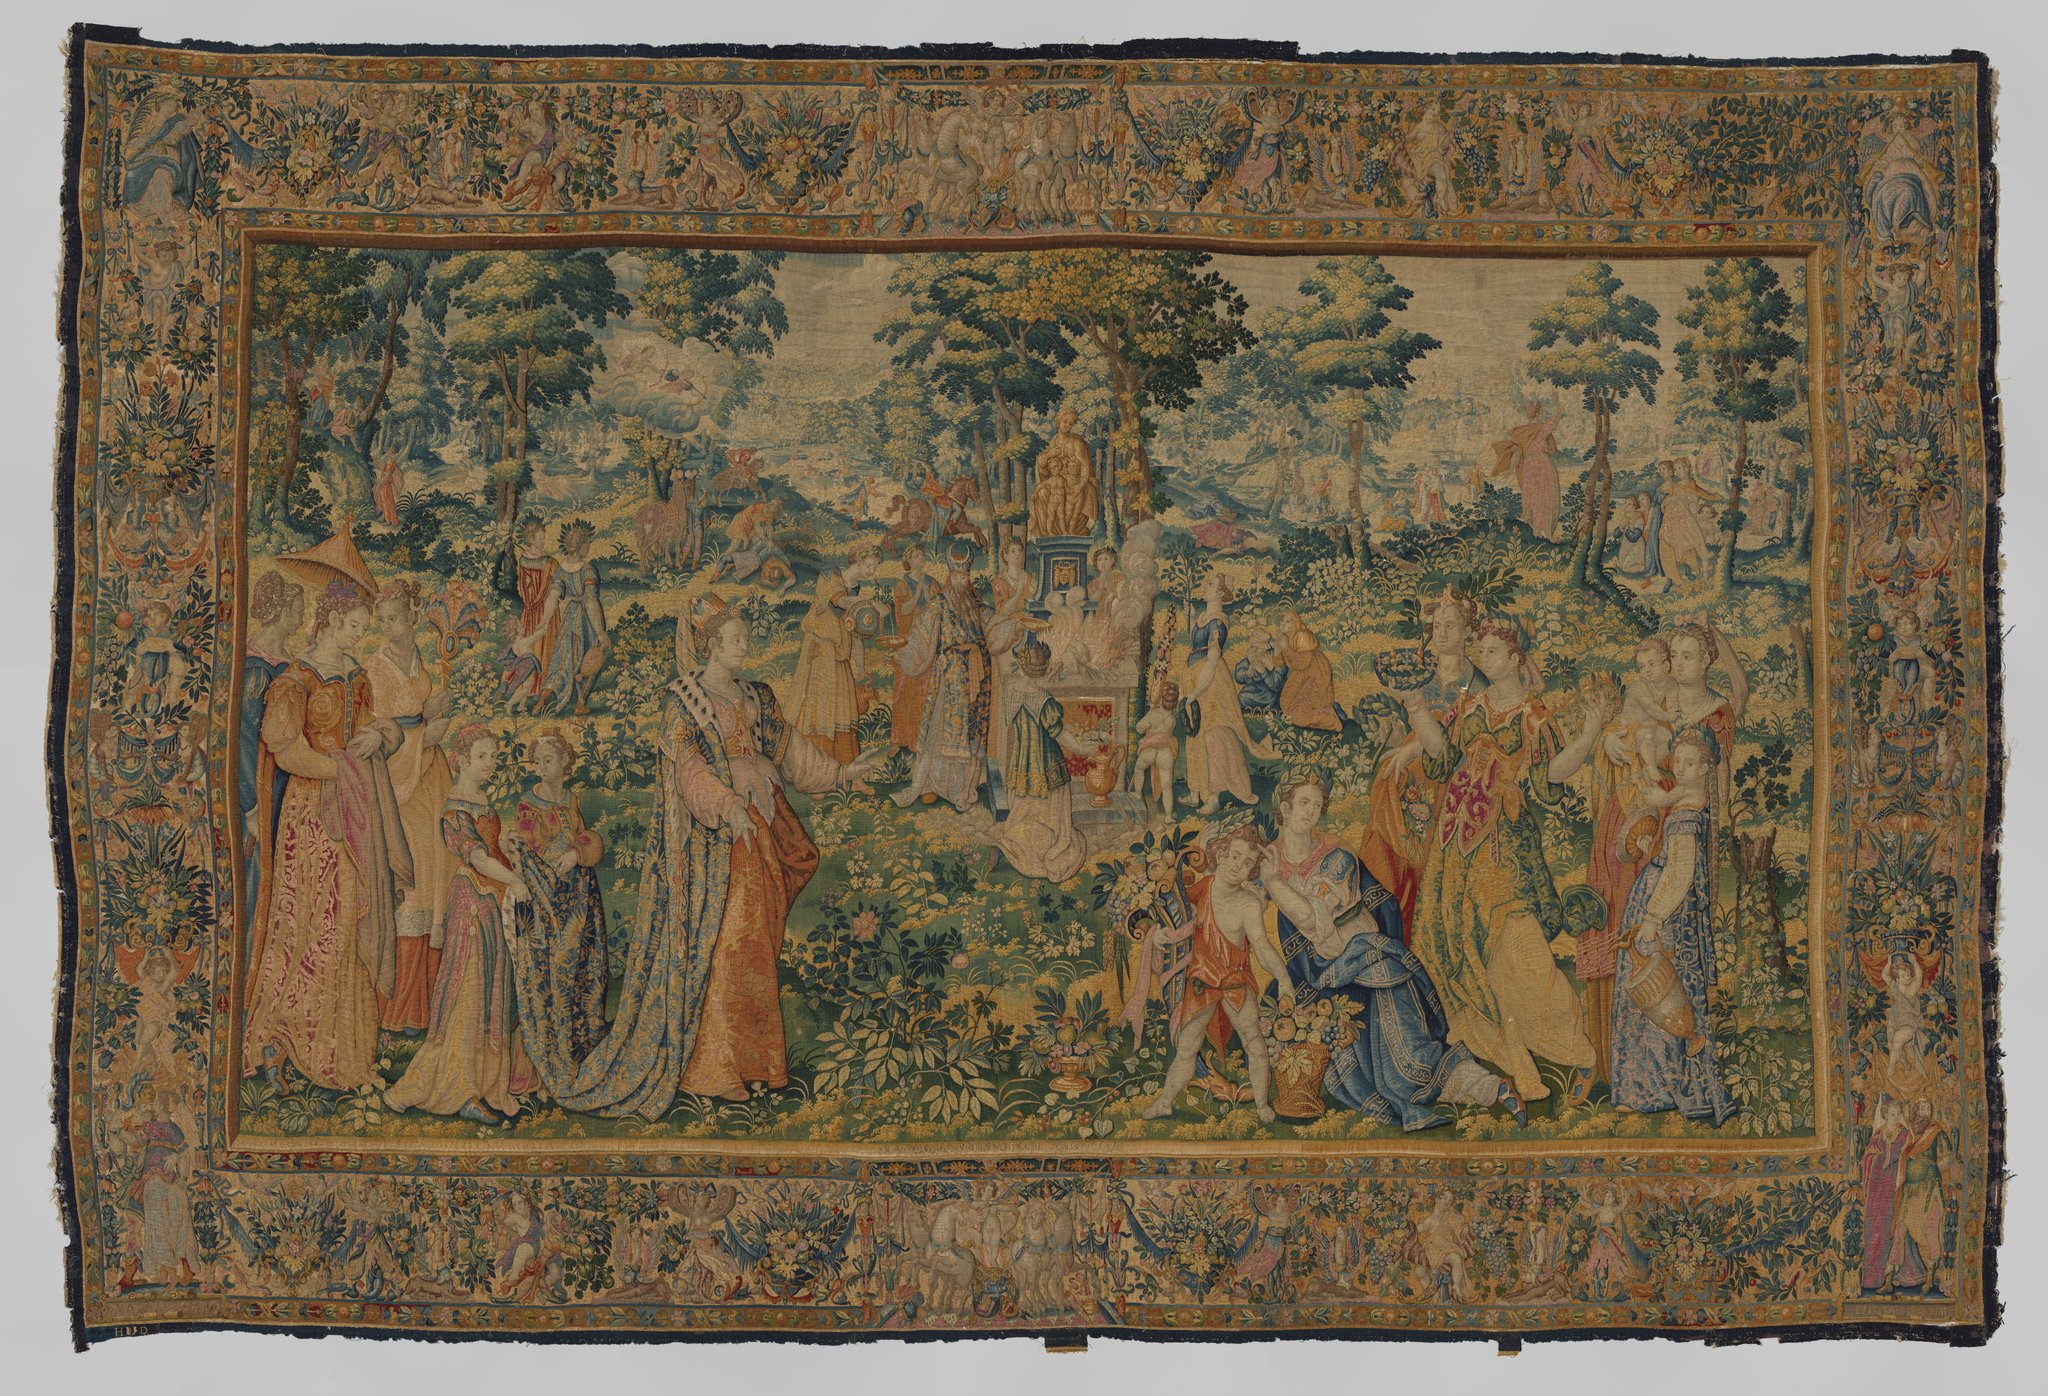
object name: tapestry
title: De geschiedenissen van Diana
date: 1610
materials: silk, wool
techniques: tapestry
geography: delft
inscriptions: inscription: ‘IVPITER ET CALLISTO’, mark, mark, signature and date: ‘FRANCISCVS.SPIRINVS.FECIT.ANNO 1610’, inscription: ‘MARS ET VENUS’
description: Niobe gekleed in een blauwe mantel van 14de eeuws Lucca brocaat, afgezet met hermelijn, gevolgd door sleepdraagstertjes en dienaren, spreekt een groep vrouwen en kinderen toe. Op het middenplan een brandend altaar waarop een gouden beeld van Latona met de tweeling. Links staat een priester, die een plengoffer brengt, rondom offerende en smekende vrouwen. Links de goddelijke vergelding: Niobe's vluchtende kinderen worden gedood door de pijlen, die Apollo en Diana vanuit de wolken op hen afschieten. In de bovenhoeken Pax en Fama, in de benedenhoeken telkens twee mythologische figuren: links Mars et Venus; rechts Jupiter et Calisto. Gemerkt met het stadsmerk van Delft, links in de blauwe benedenzoom: H D (Holland Delft) getekend tussen boord em midden FRANCISCUS.SPIRINGIUS.FECIT.ANNO 1610. In de rechter blauwe zoom zit het weversmerk.